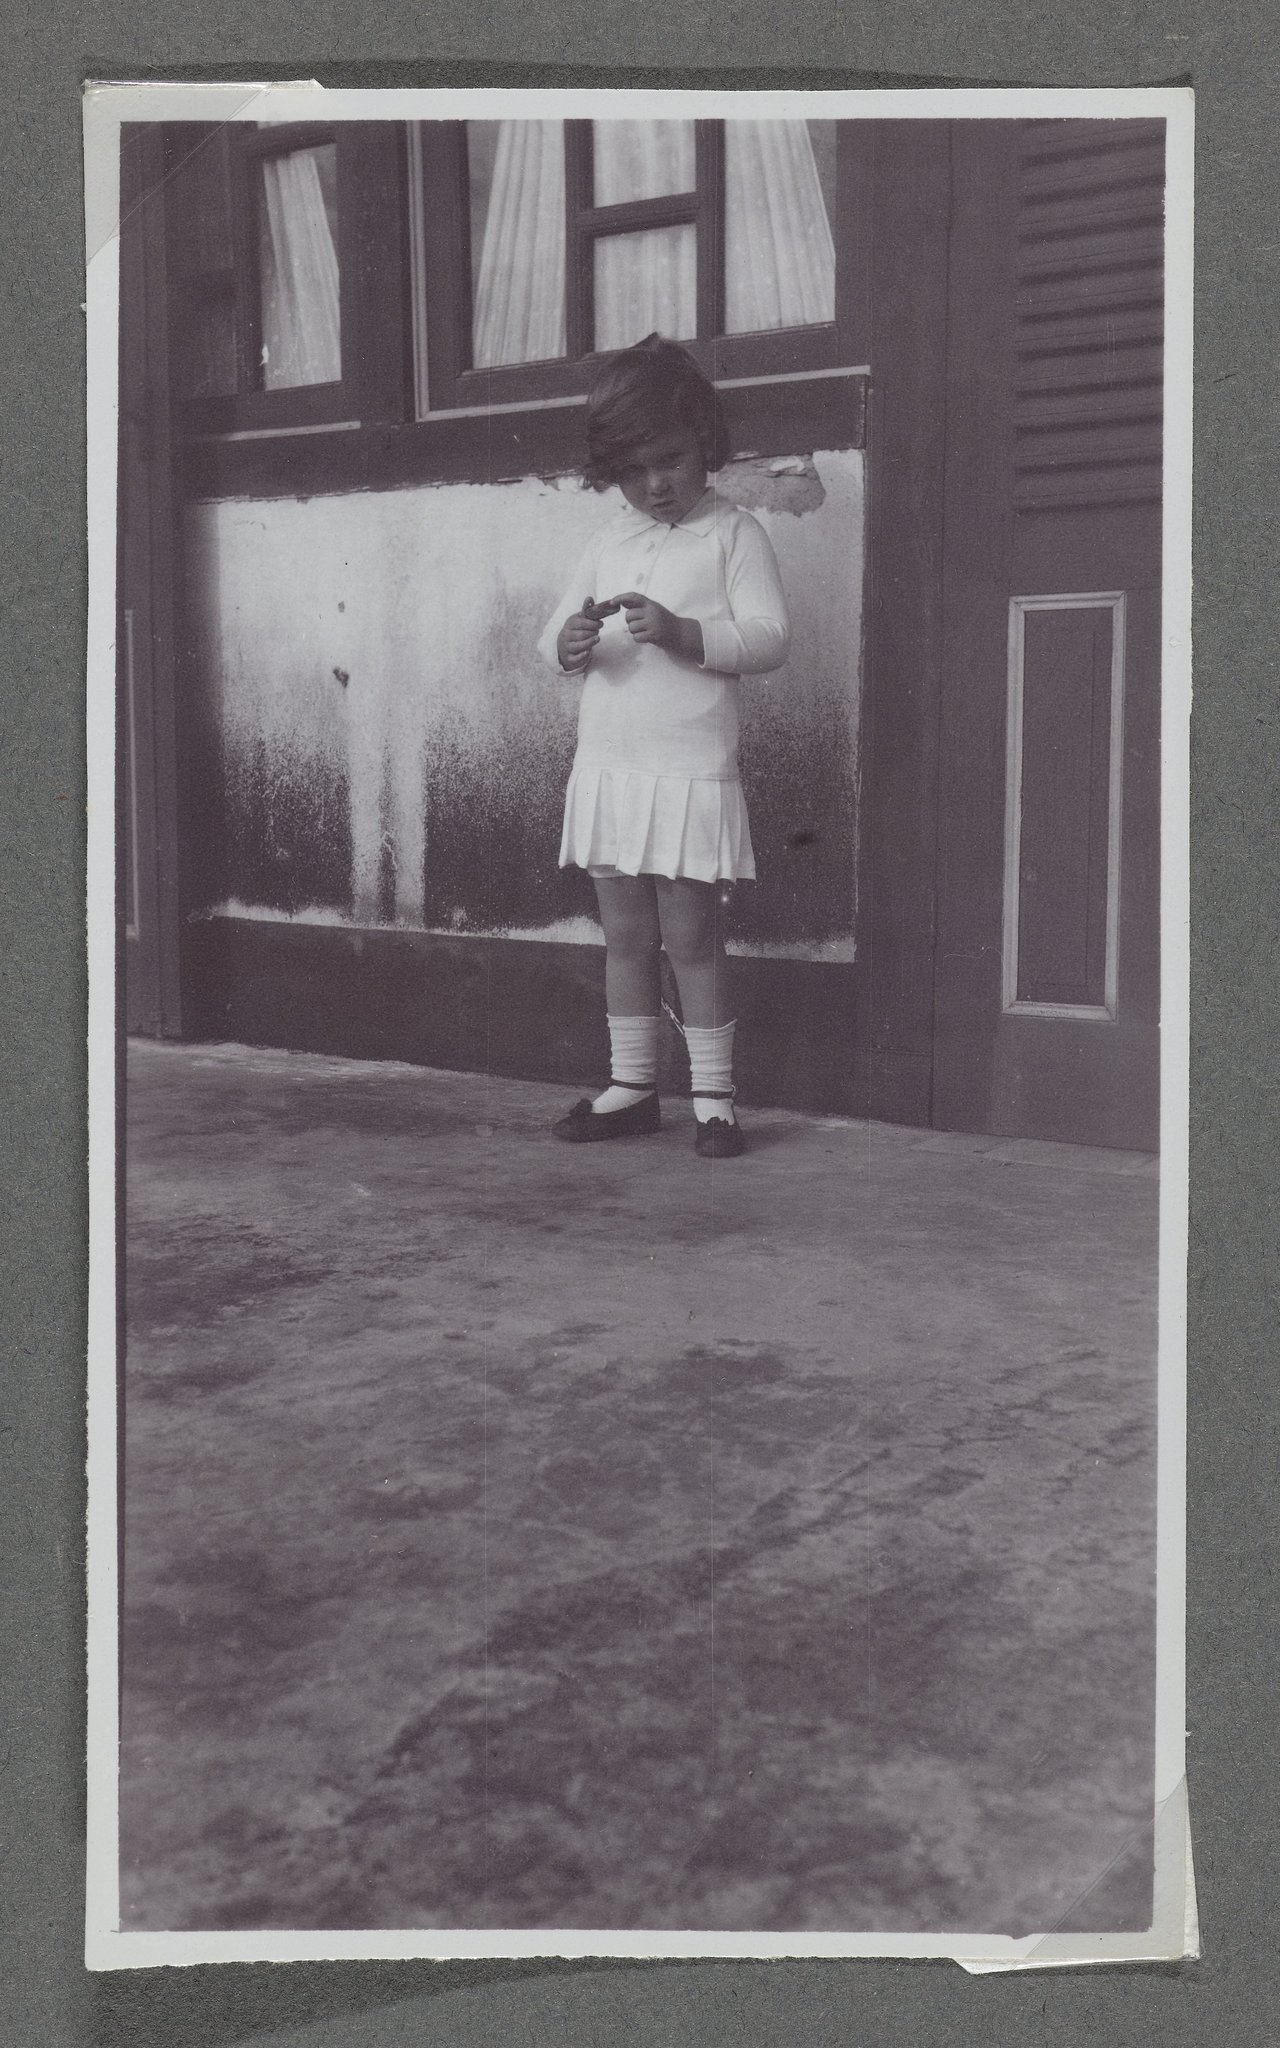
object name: photograph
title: Tiny Kleiterp staand voor een huis in Adiwerna op Java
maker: klaas kleiterp (i)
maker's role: arts, officier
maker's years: 1892-1943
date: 1903-1925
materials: paper, photographic support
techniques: gelatin silver print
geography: adiwerna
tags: child, dutch east indies, the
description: Onderdeel van Fotoalbum van de familie Kleiterp-Vermeulen met opnames van de kinderen Klaas en Tiny in Nederlands-Indië.